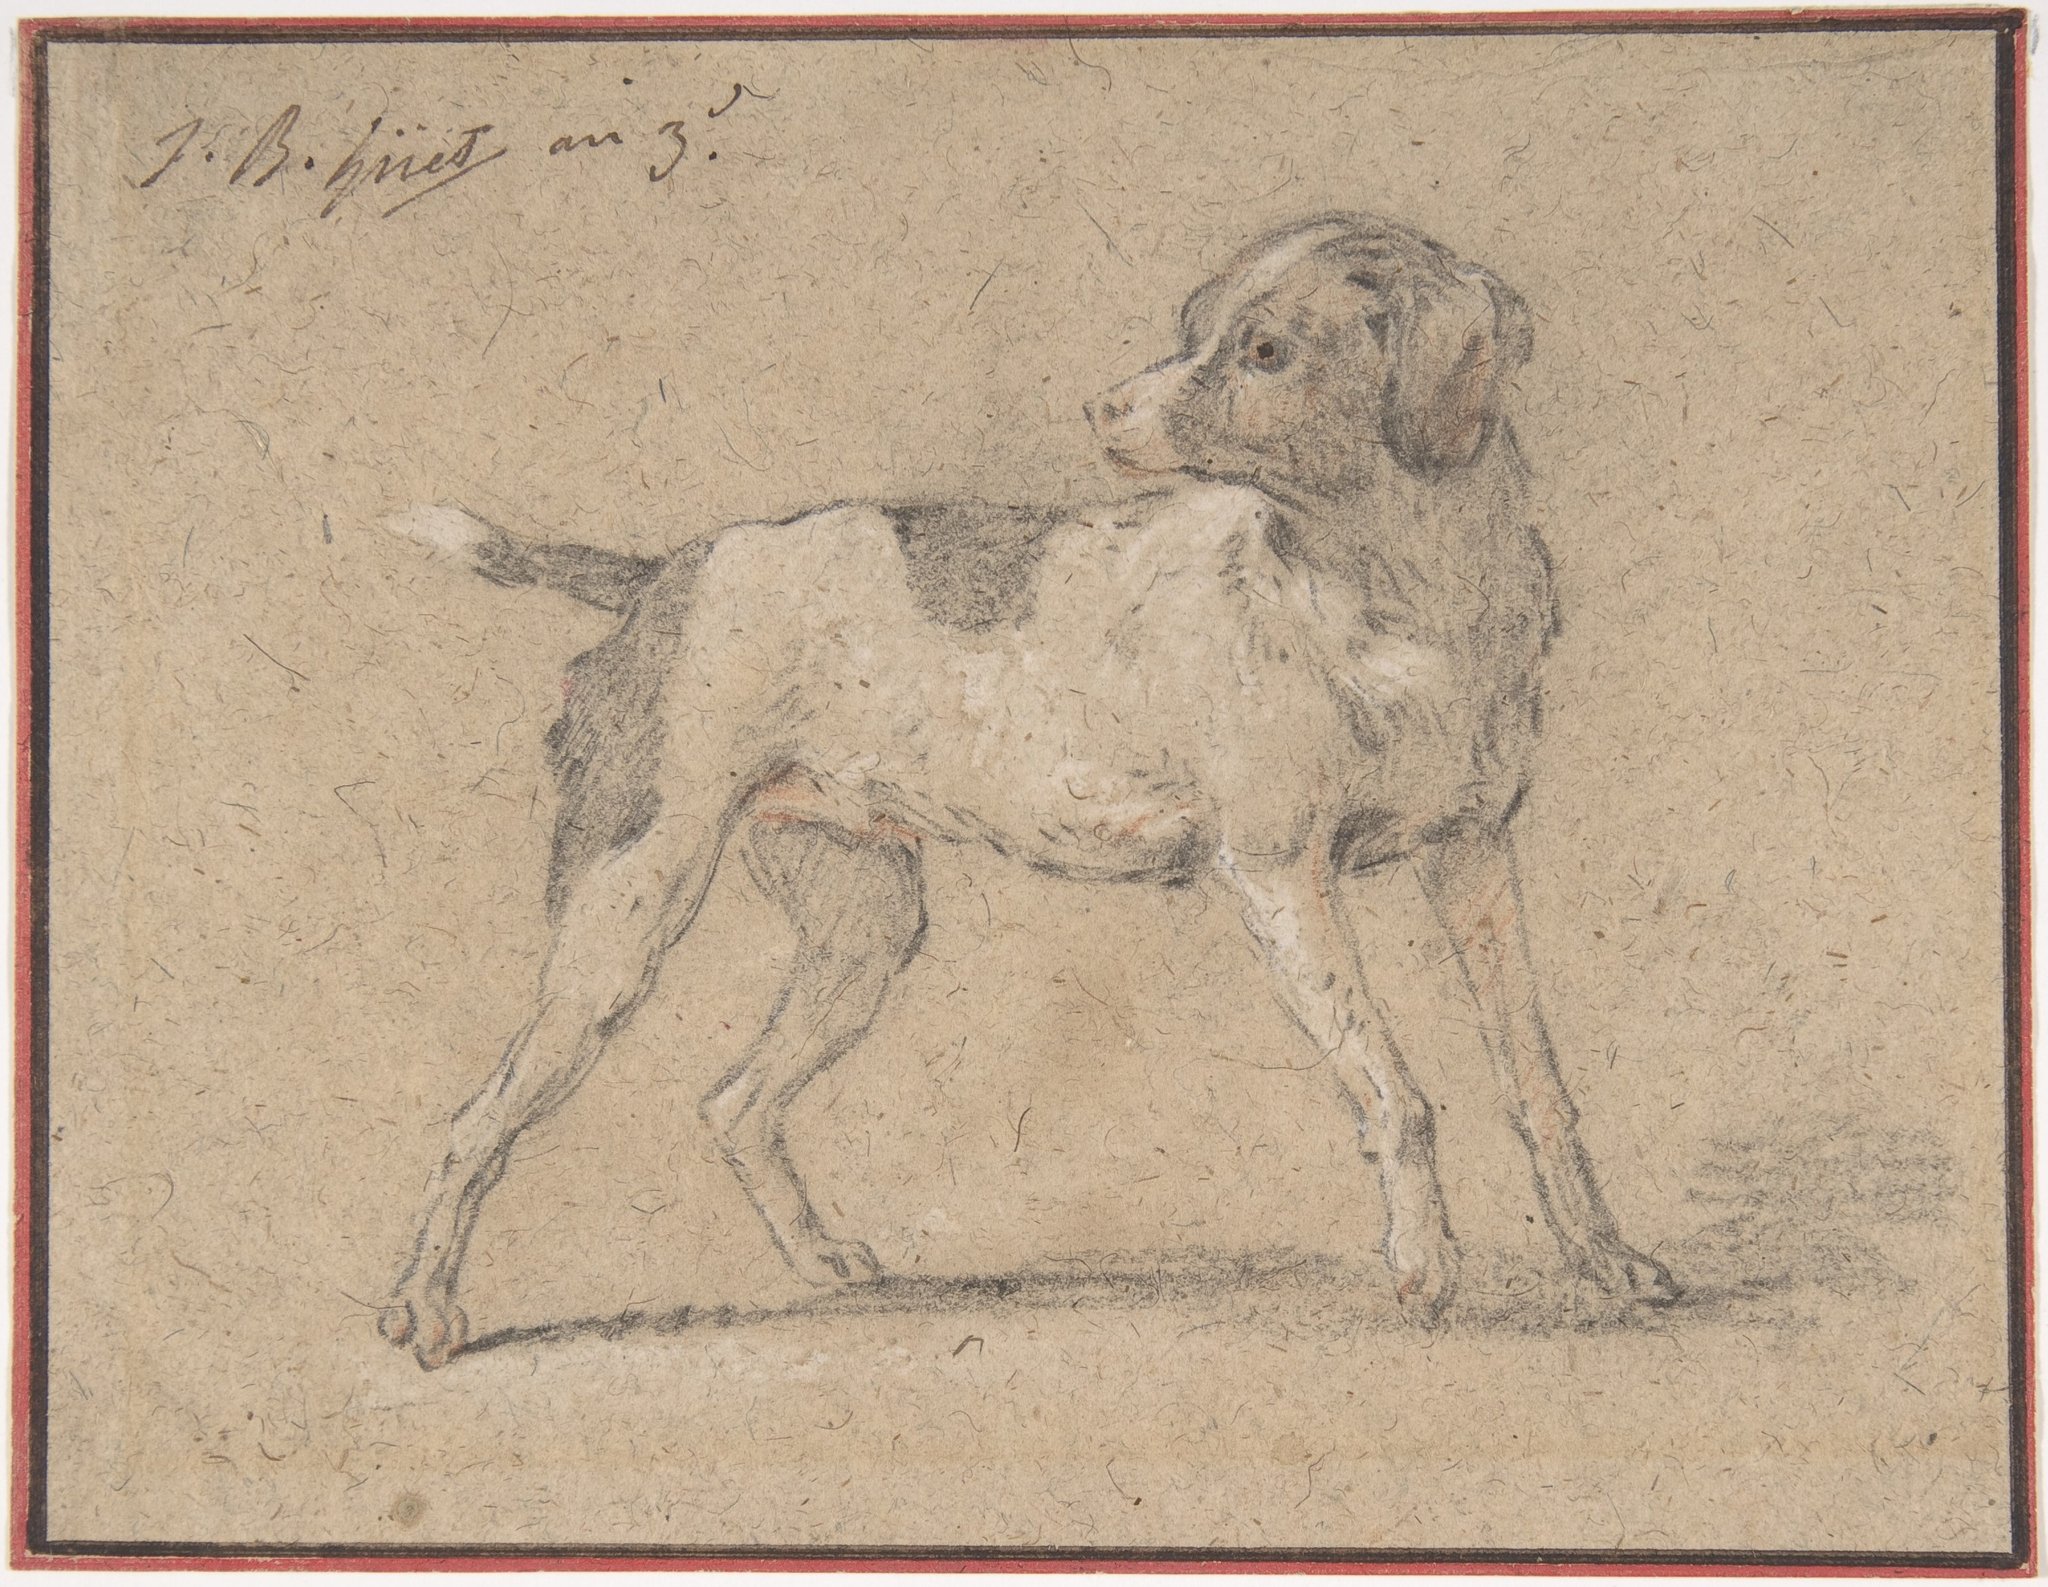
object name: drawing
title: Black and White Dog, Head Turned to the Left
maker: jean-baptiste huet i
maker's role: artist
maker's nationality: french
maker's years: 1745-1811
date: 1794-1795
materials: chalk, graphite, paper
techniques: heightening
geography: france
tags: dogs